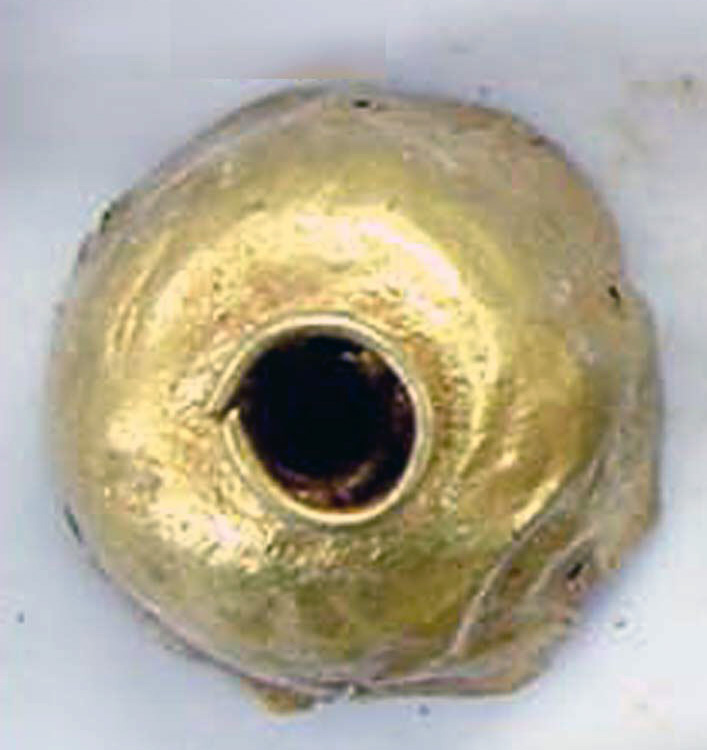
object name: plaque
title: Flower-Shaped Plaque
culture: northwest chinese or eastern central asian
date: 634-900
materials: gold